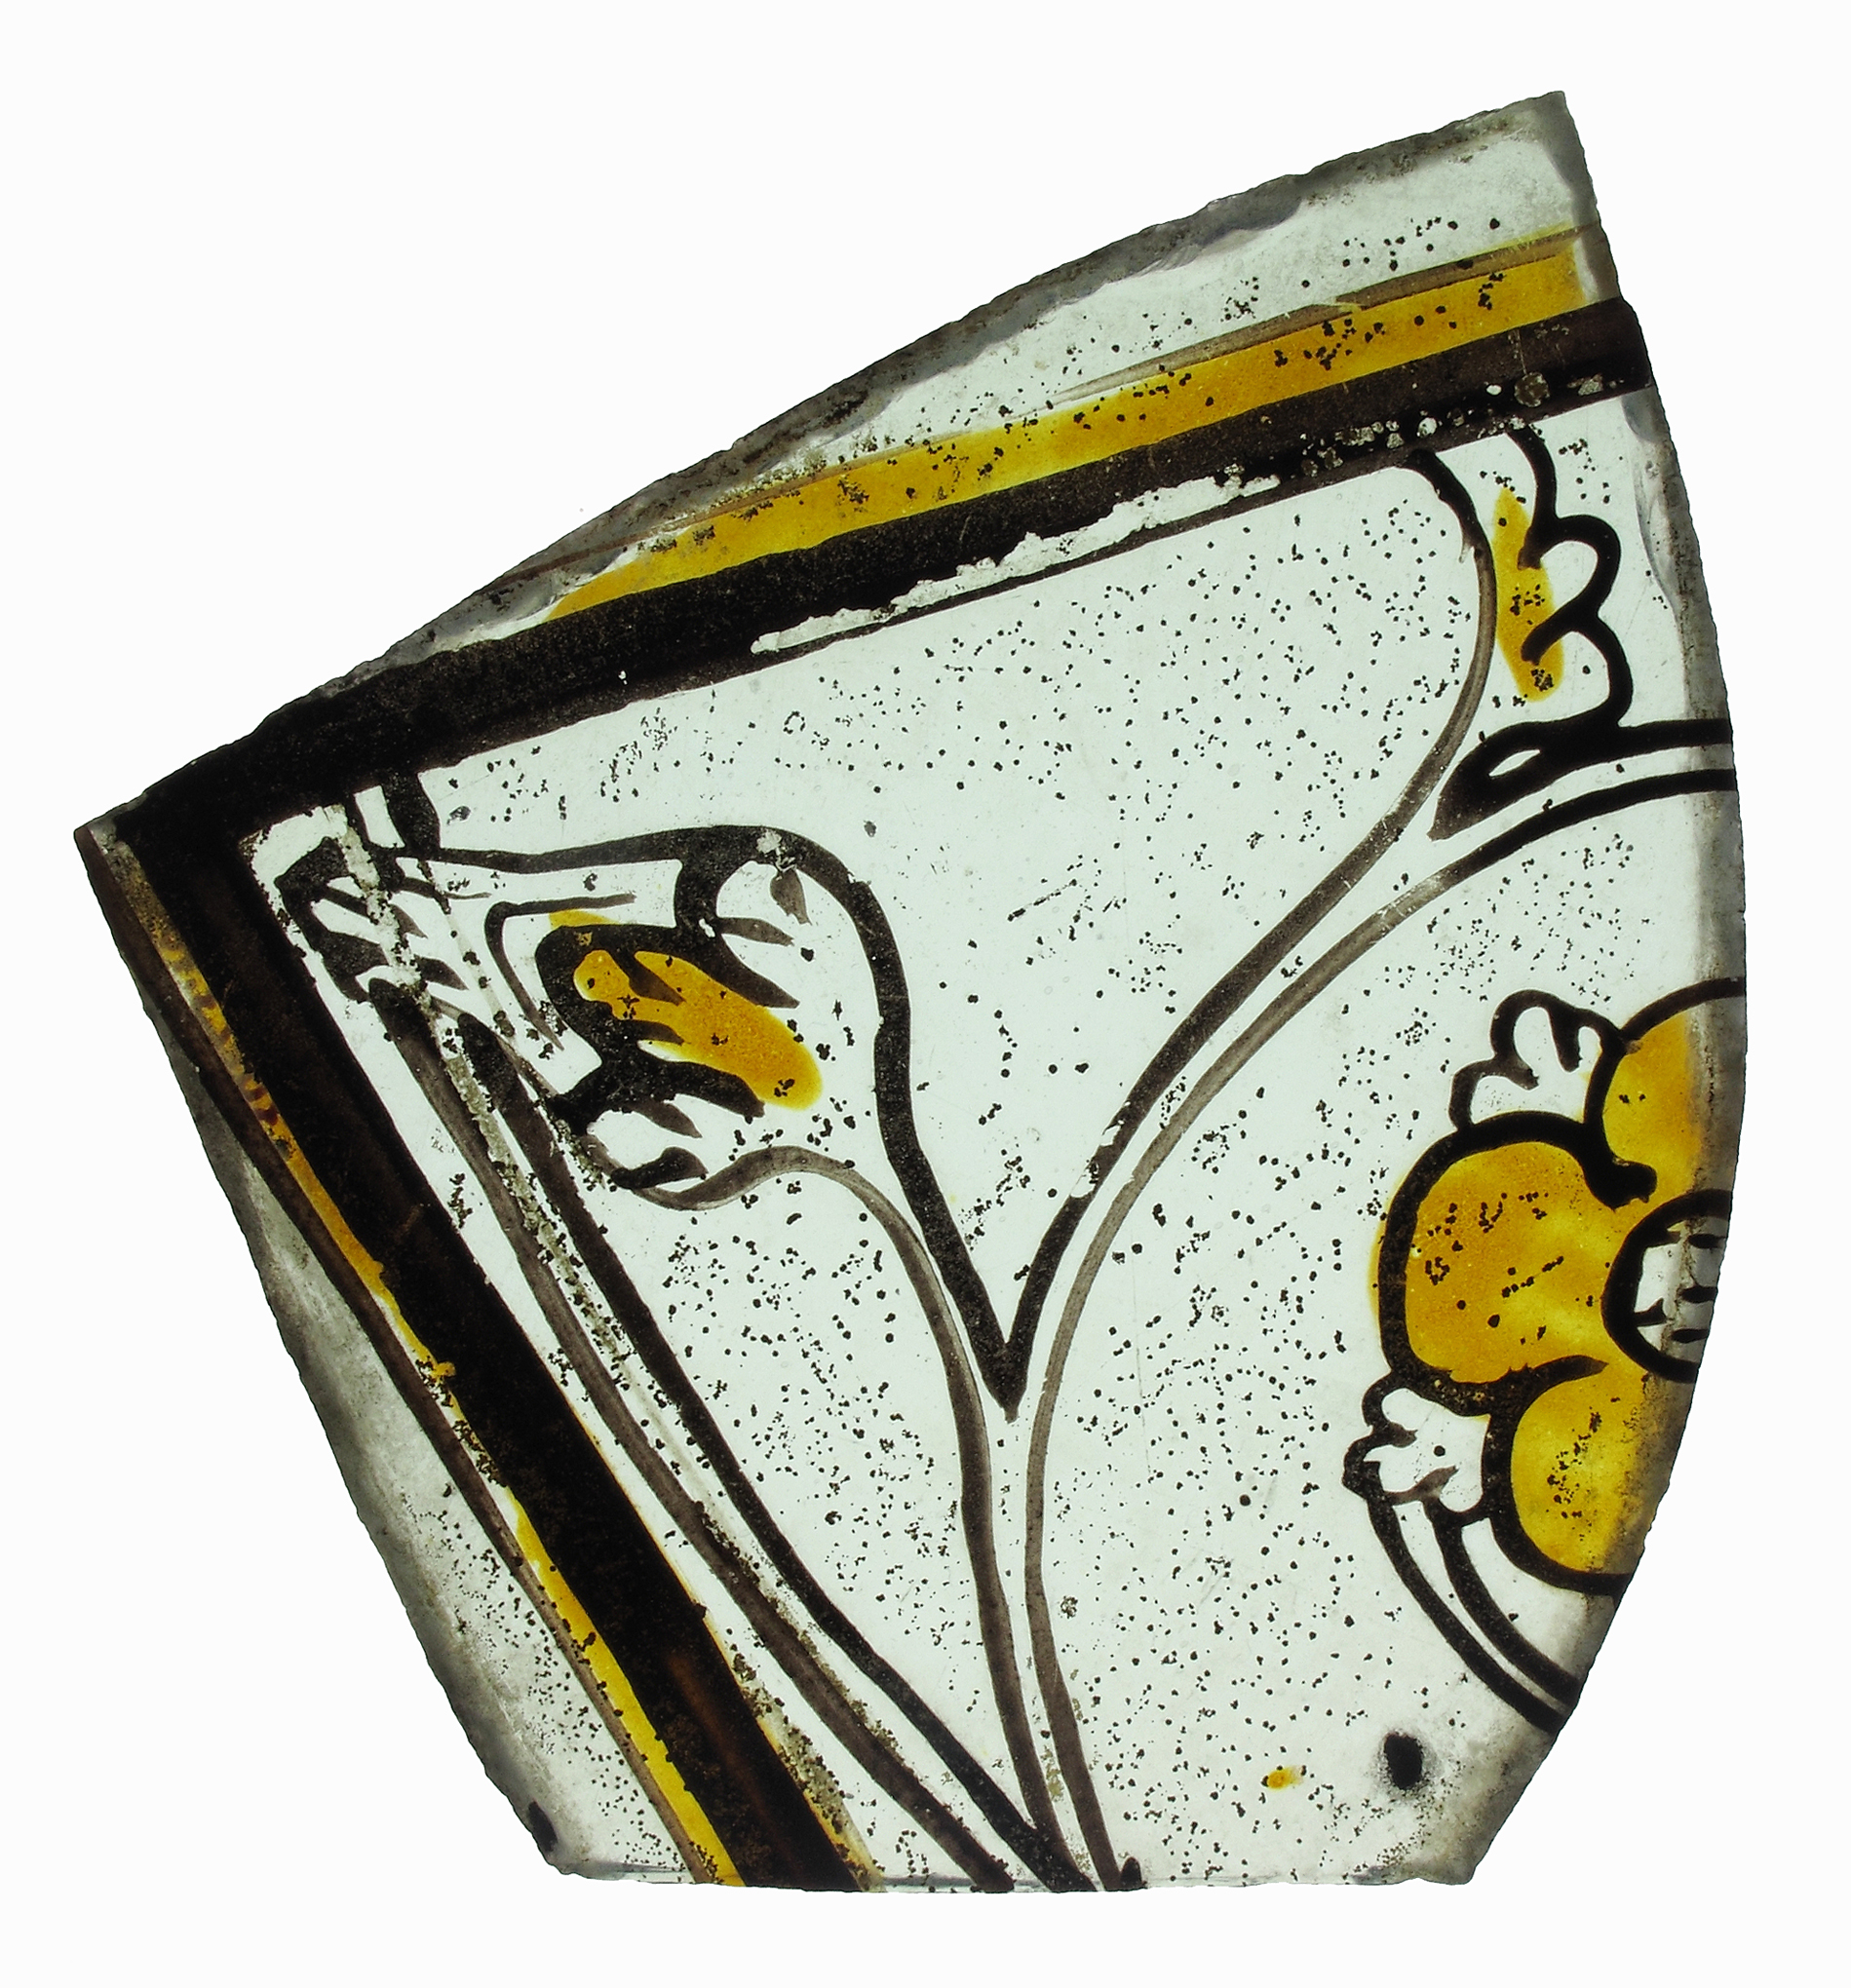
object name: fragment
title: Glass Fragment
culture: european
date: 1400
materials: glass